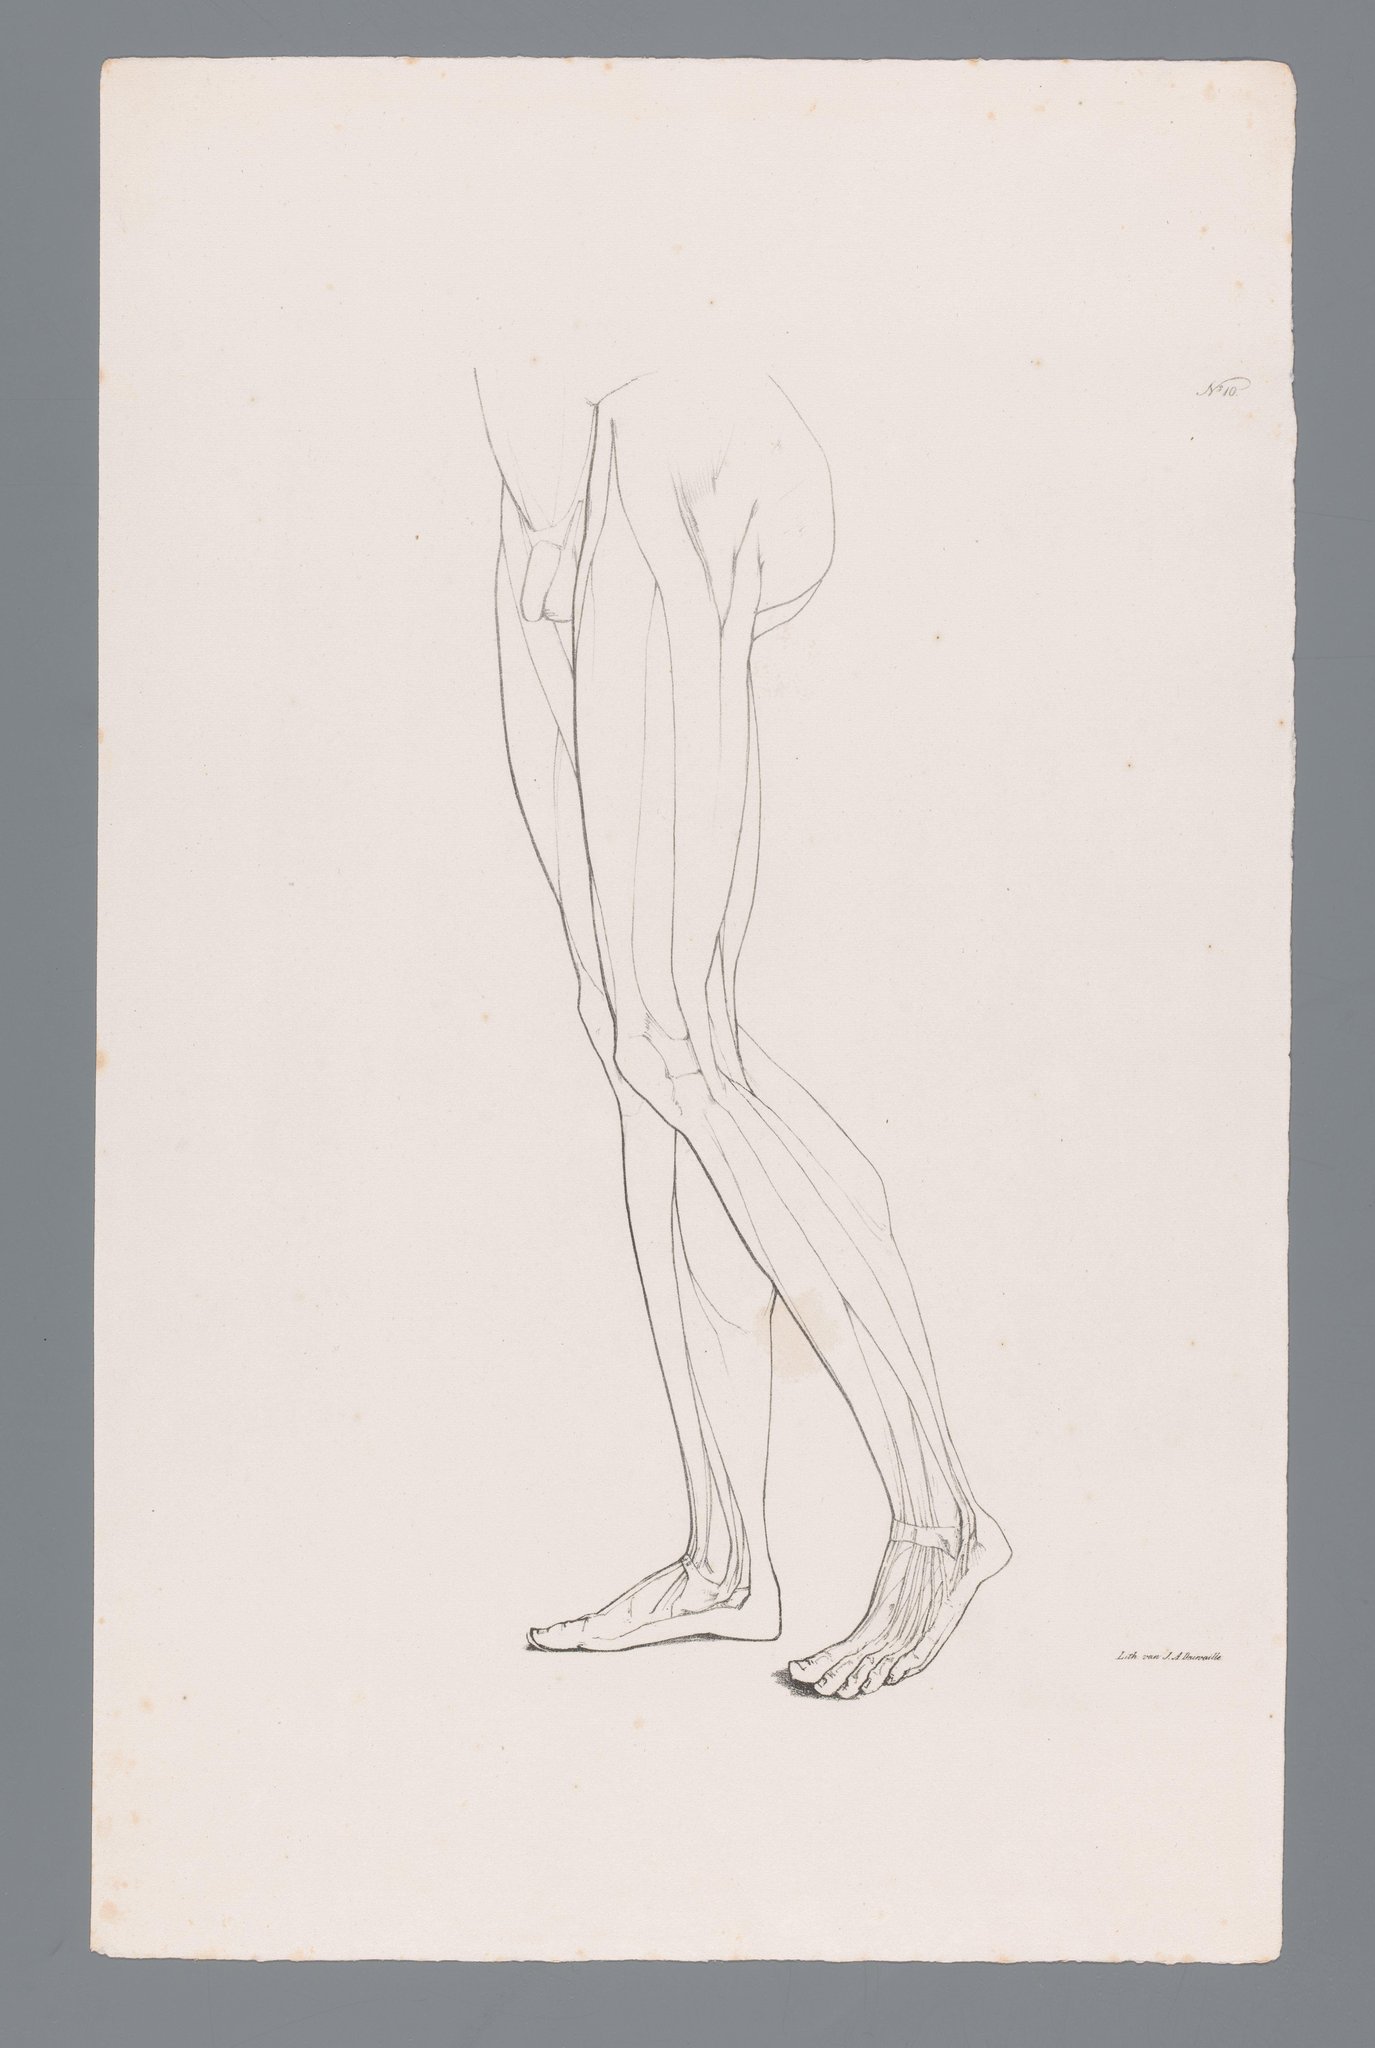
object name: print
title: Anatomie-studien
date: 1828-1830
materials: paper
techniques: lithograph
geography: amsterdam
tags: legs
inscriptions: collector's mark: Lugt 2228, watermark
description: Van de zijkant gezien. Onderdeel van een omslag met in totaal achttien anatomische voorstellingen.